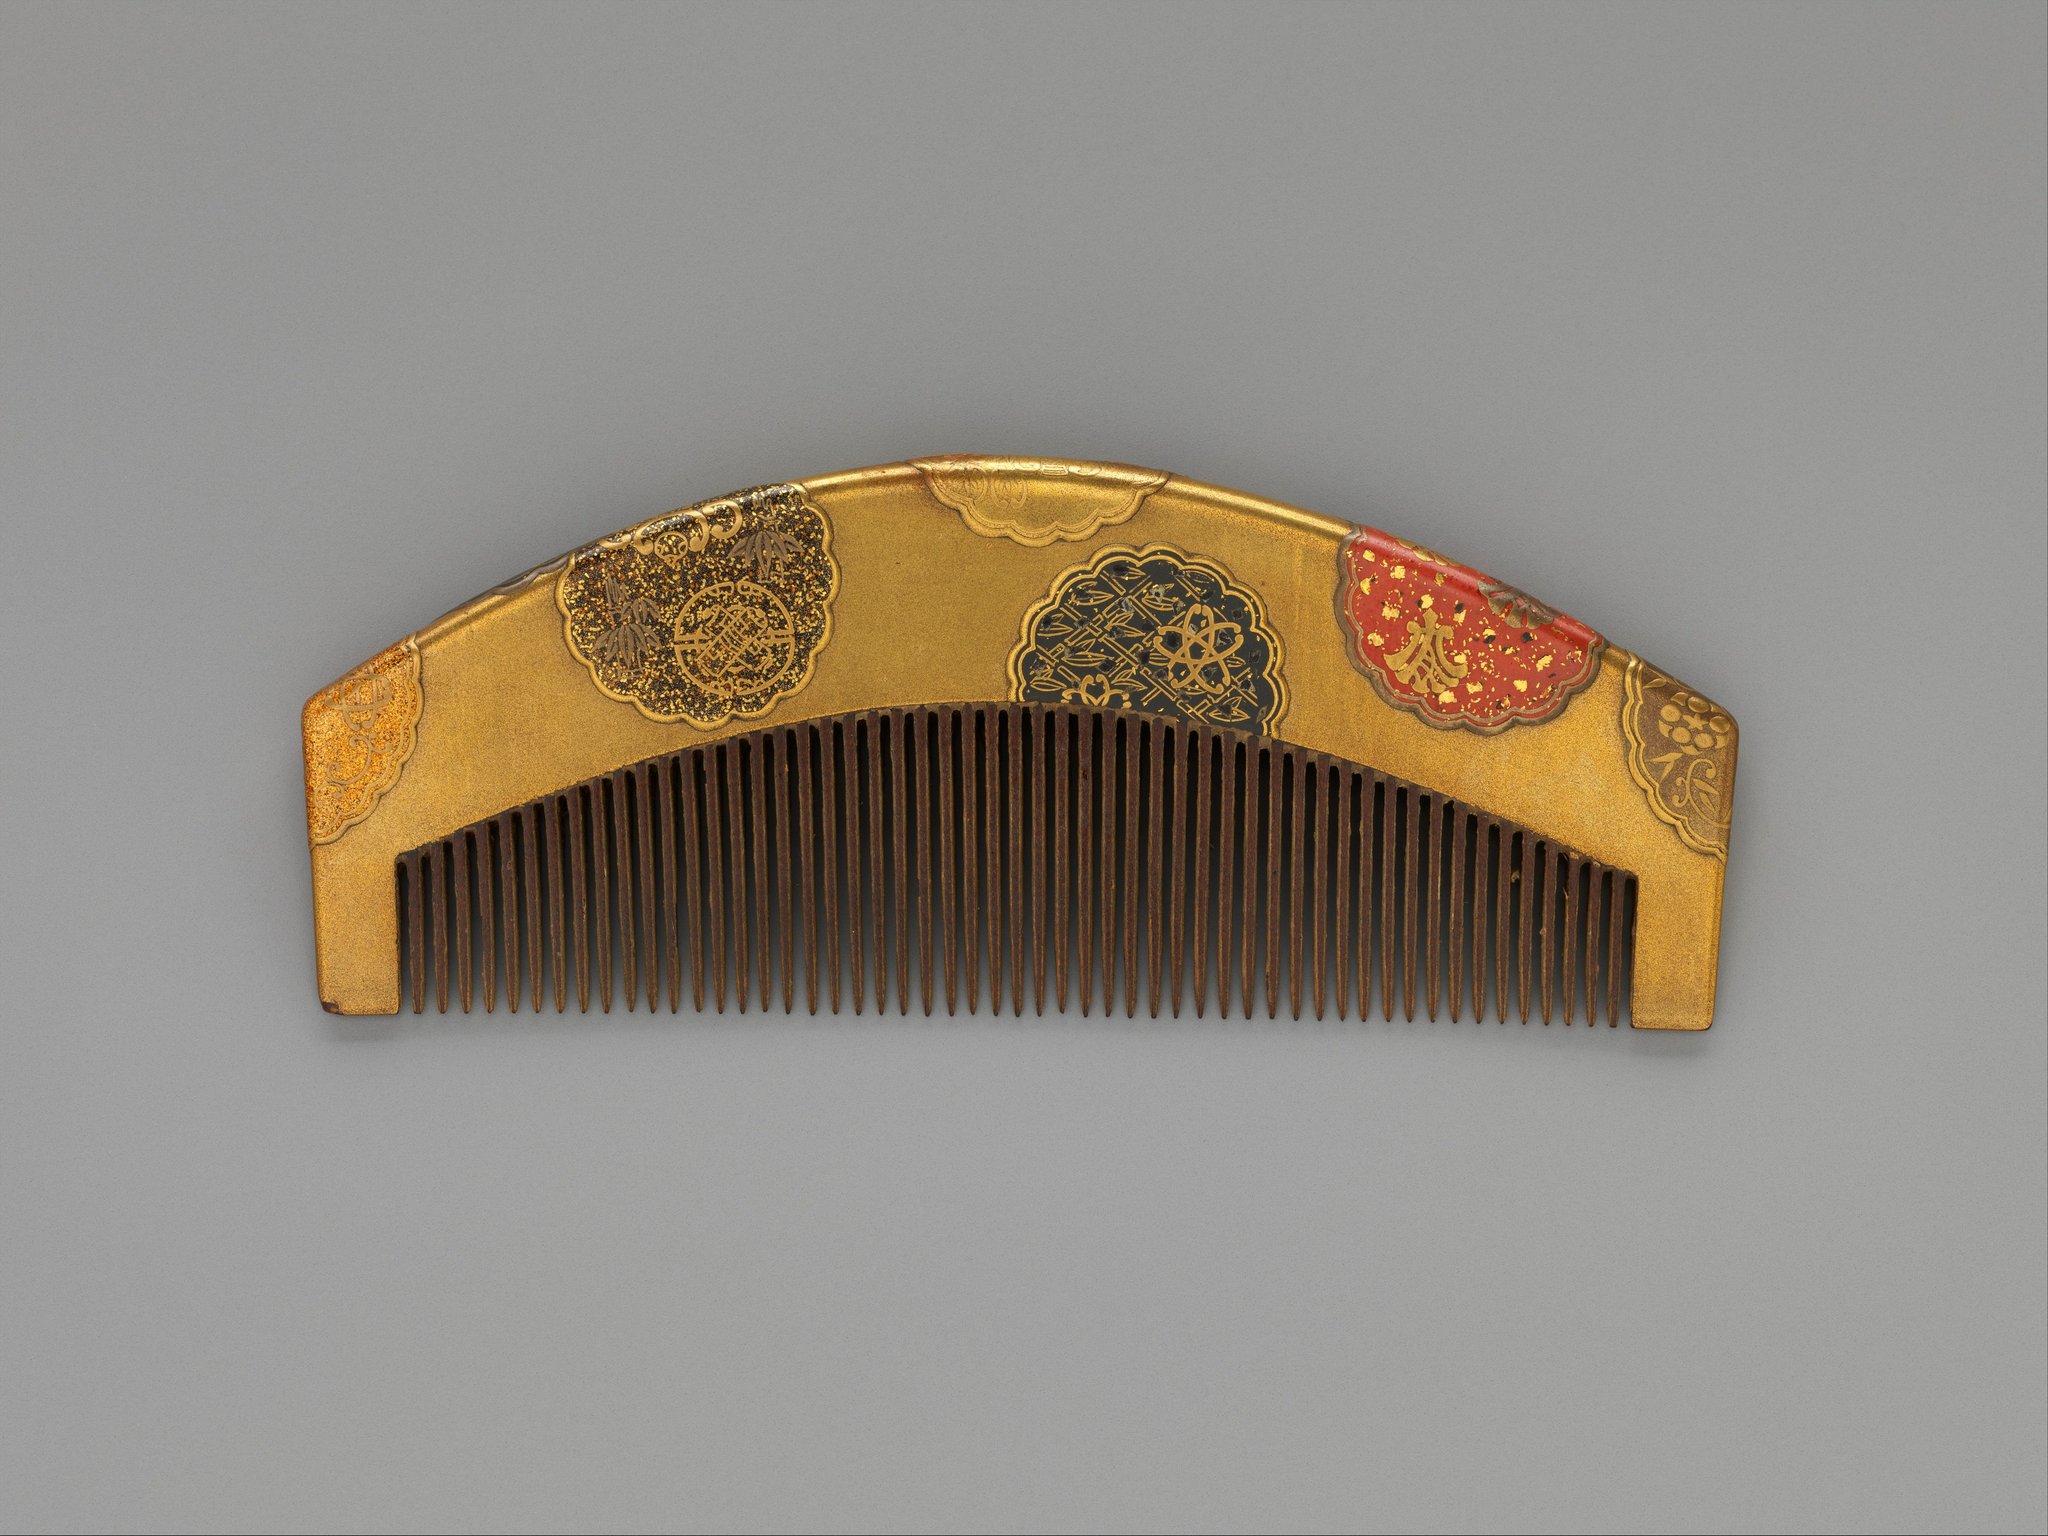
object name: comb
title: Lacquer Comb with Flower-Shaped Roundels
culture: japanese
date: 1834-1866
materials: gold, gold leaf, silver, wood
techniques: hiramakie, lacquer